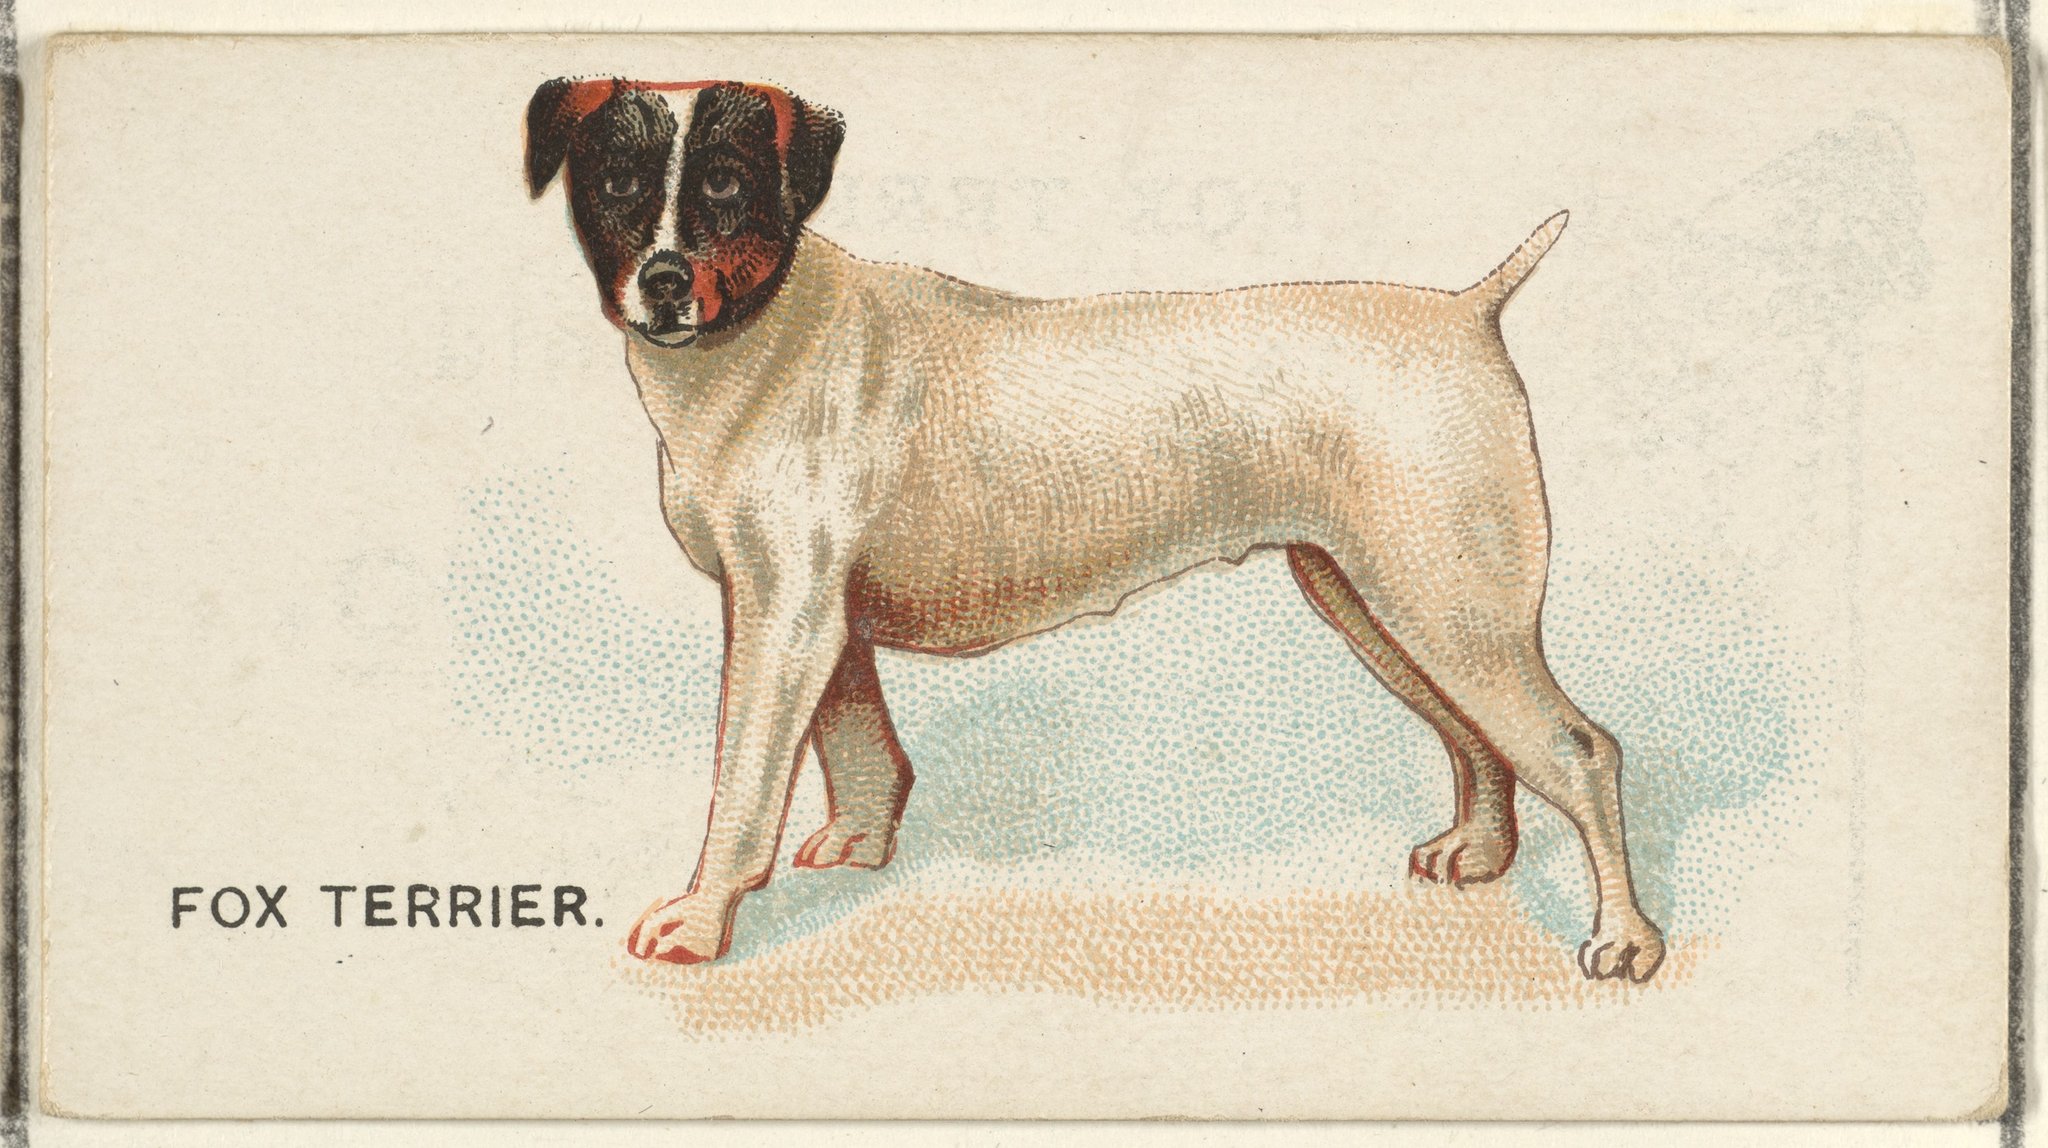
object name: print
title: Fox Terrier, from the Dogs of the World series for Old Judge Cigarettes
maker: goodwin & company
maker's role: publisher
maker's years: 1850-1950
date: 1890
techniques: color lithograph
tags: dogs